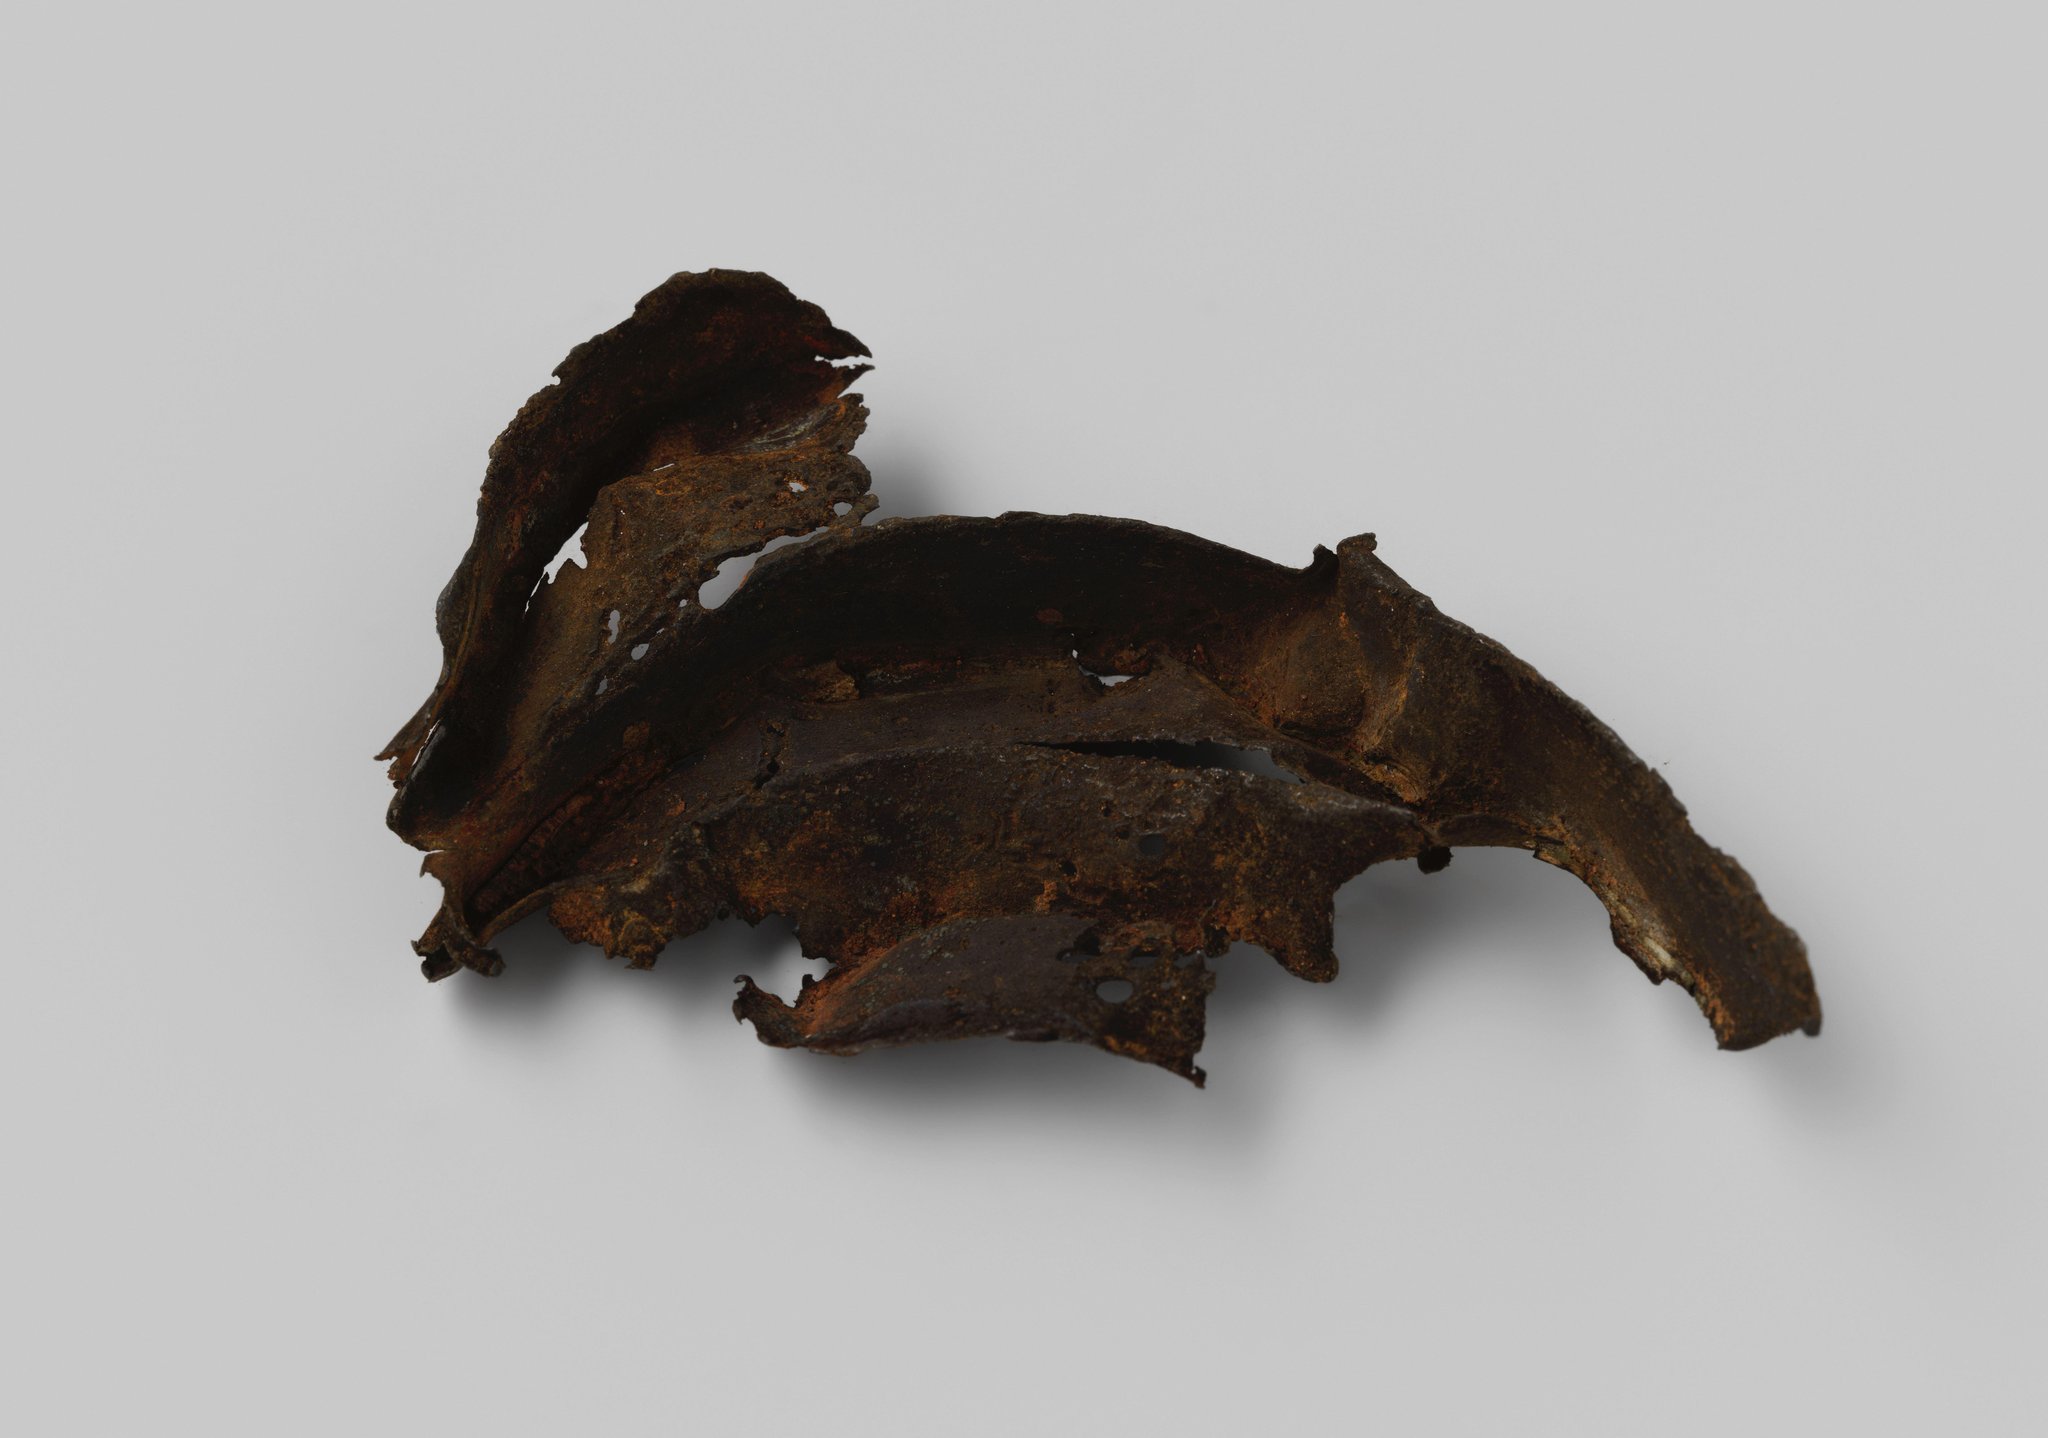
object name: fragment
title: Fragment uit het wrak van de Oost-Indiëvaarder Hollandia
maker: Anonymous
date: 1700-1743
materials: copper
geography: netherlands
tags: verenigde oostindische compagnie, hollandia (schip), annet